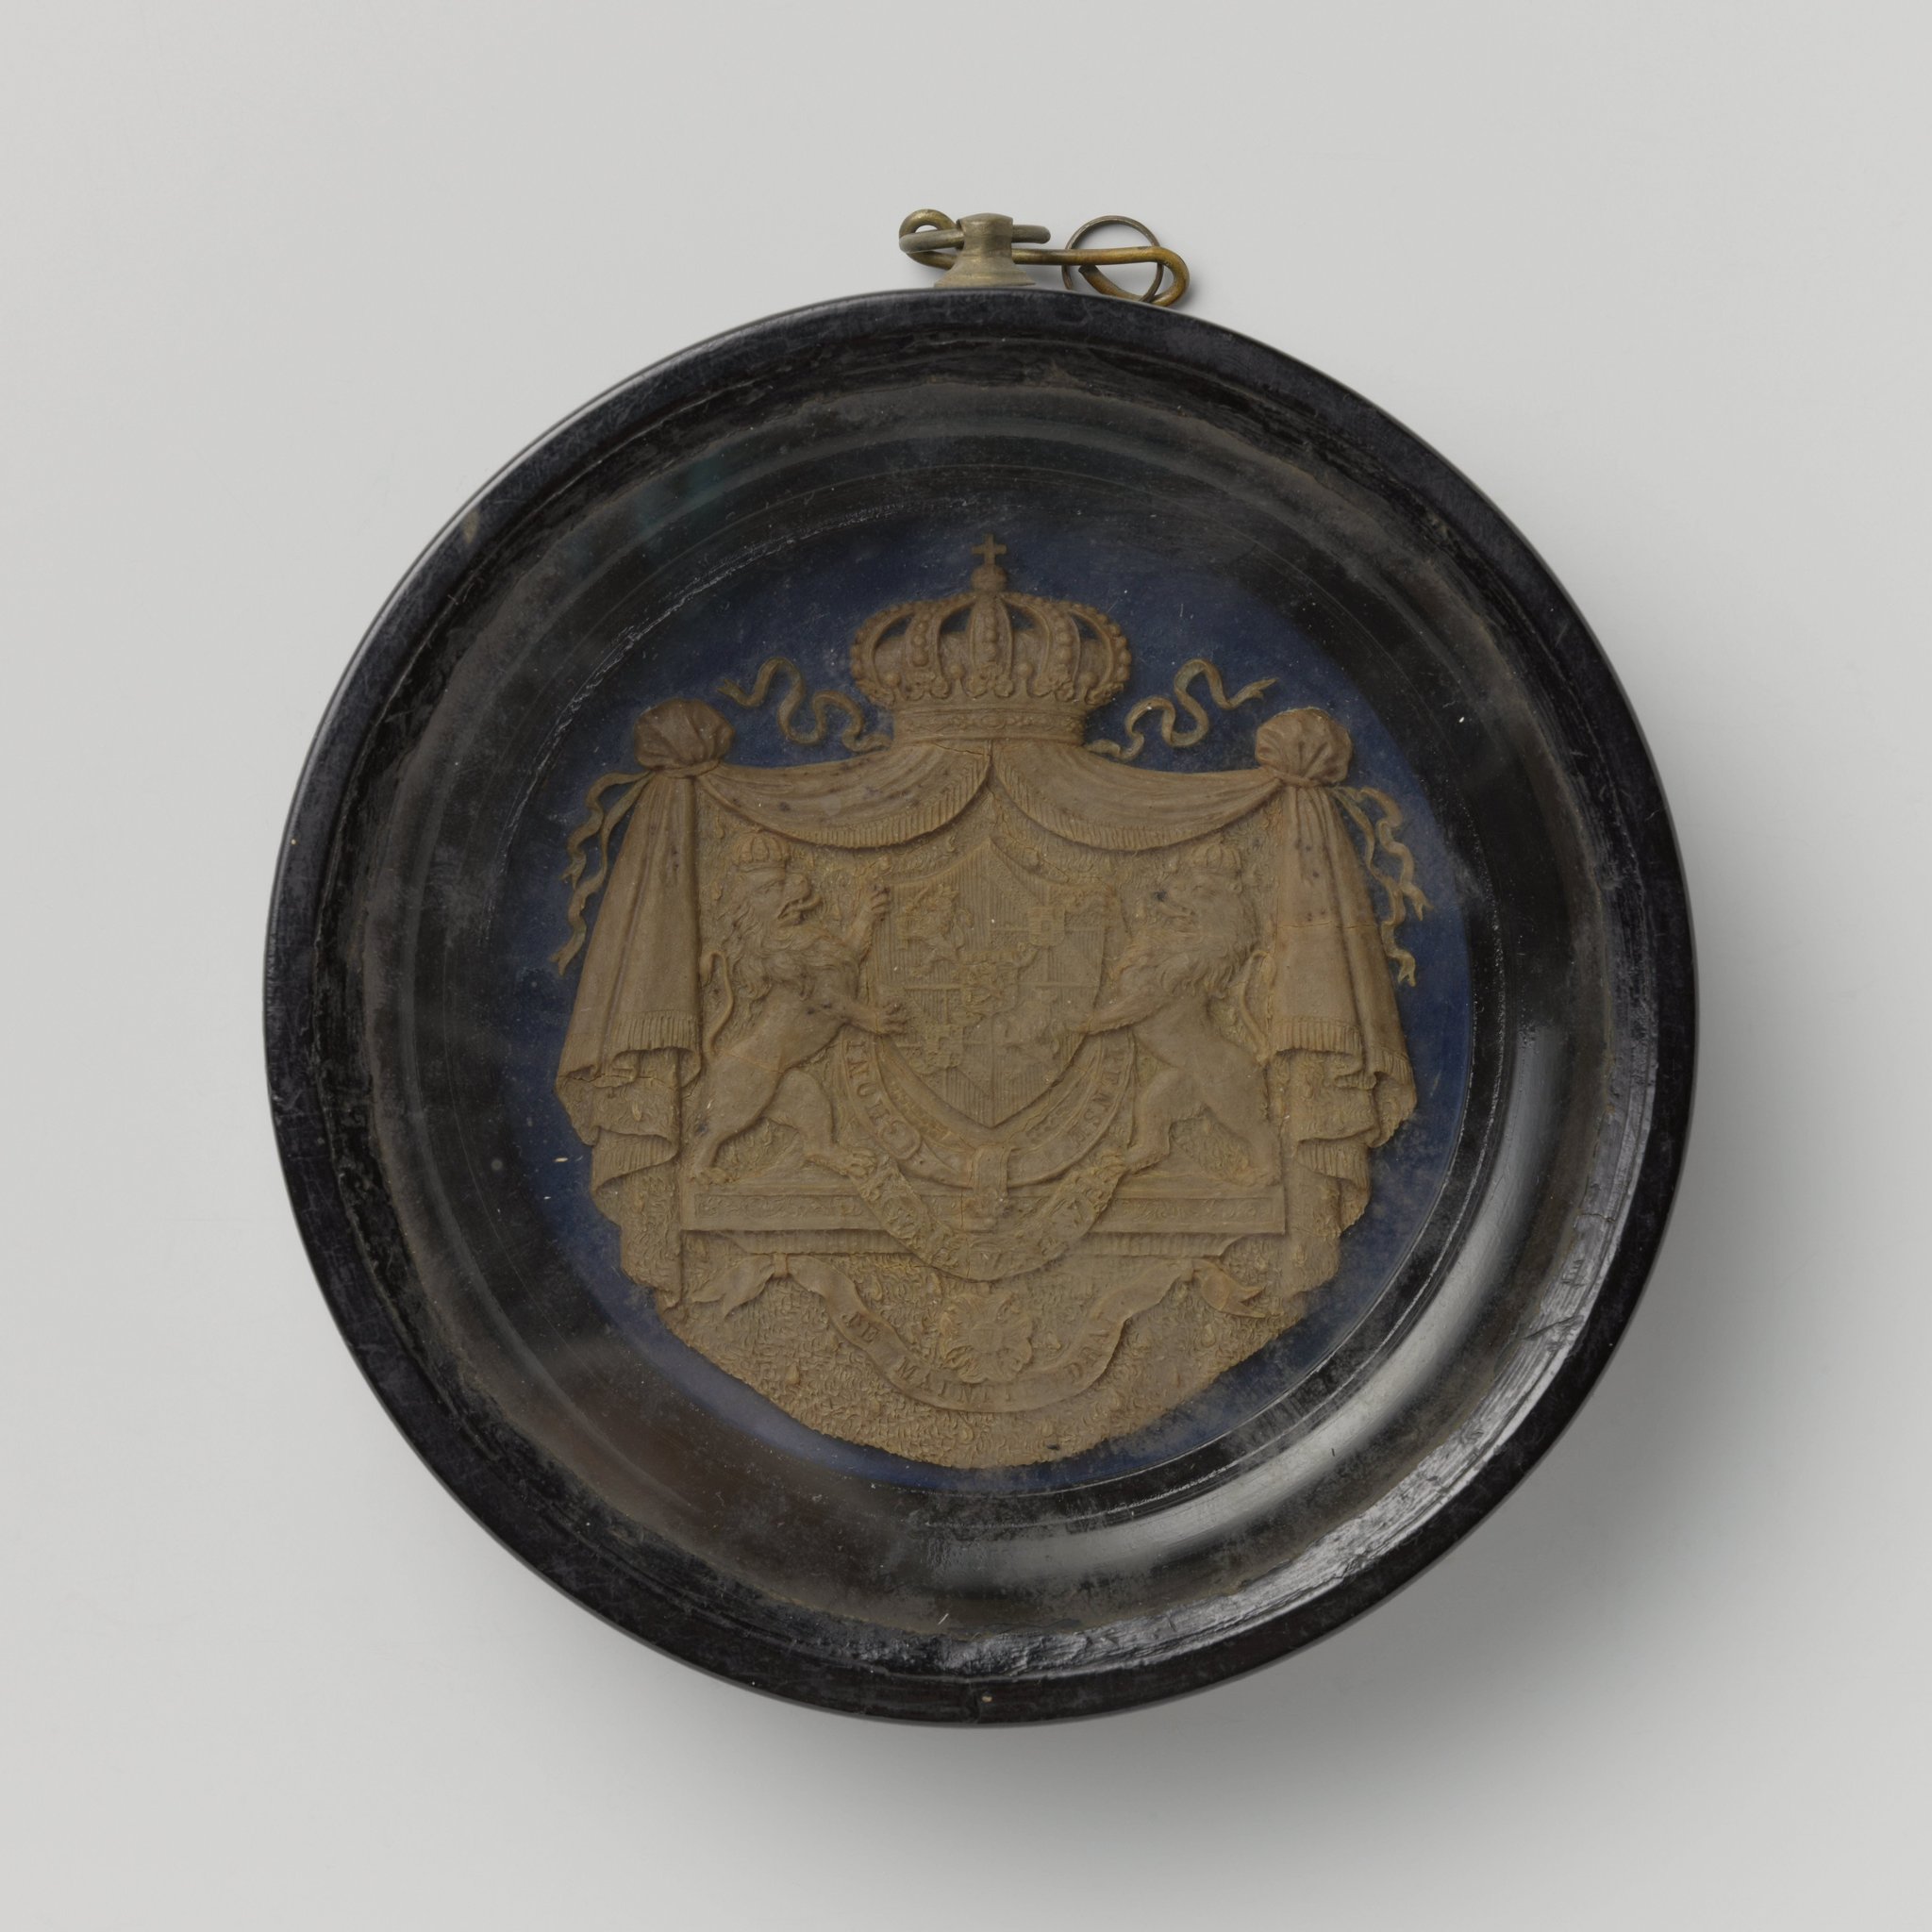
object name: wapenbord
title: Wapen van koning Willem I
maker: Anonymous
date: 1815-1840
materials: glass, wax, wood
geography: netherlands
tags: the hague, berlin, william i of the netherlands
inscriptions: inscription: ‘De soevereine Vorst der Vereen : Nederl : voerde een...’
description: Wapen van Willem I Frederik, koning der Nederlanden in ronde zwarte lijst met haakje en achter glas. Twee staande gekroonde leeuwen houden wapenschild hoog. Hieronder gesp met 'HONI' en 'PENSE'. Hieronder twee banderollen, waarvan een onleesbaar. De onderste 'JE MAINTIENDRAI'. Aan weerszijden gordijnen gedrapeerd waarboven kroon. Op blauwe achtergrond. Op achterzijde lijst een etiket met tekst geplakt.